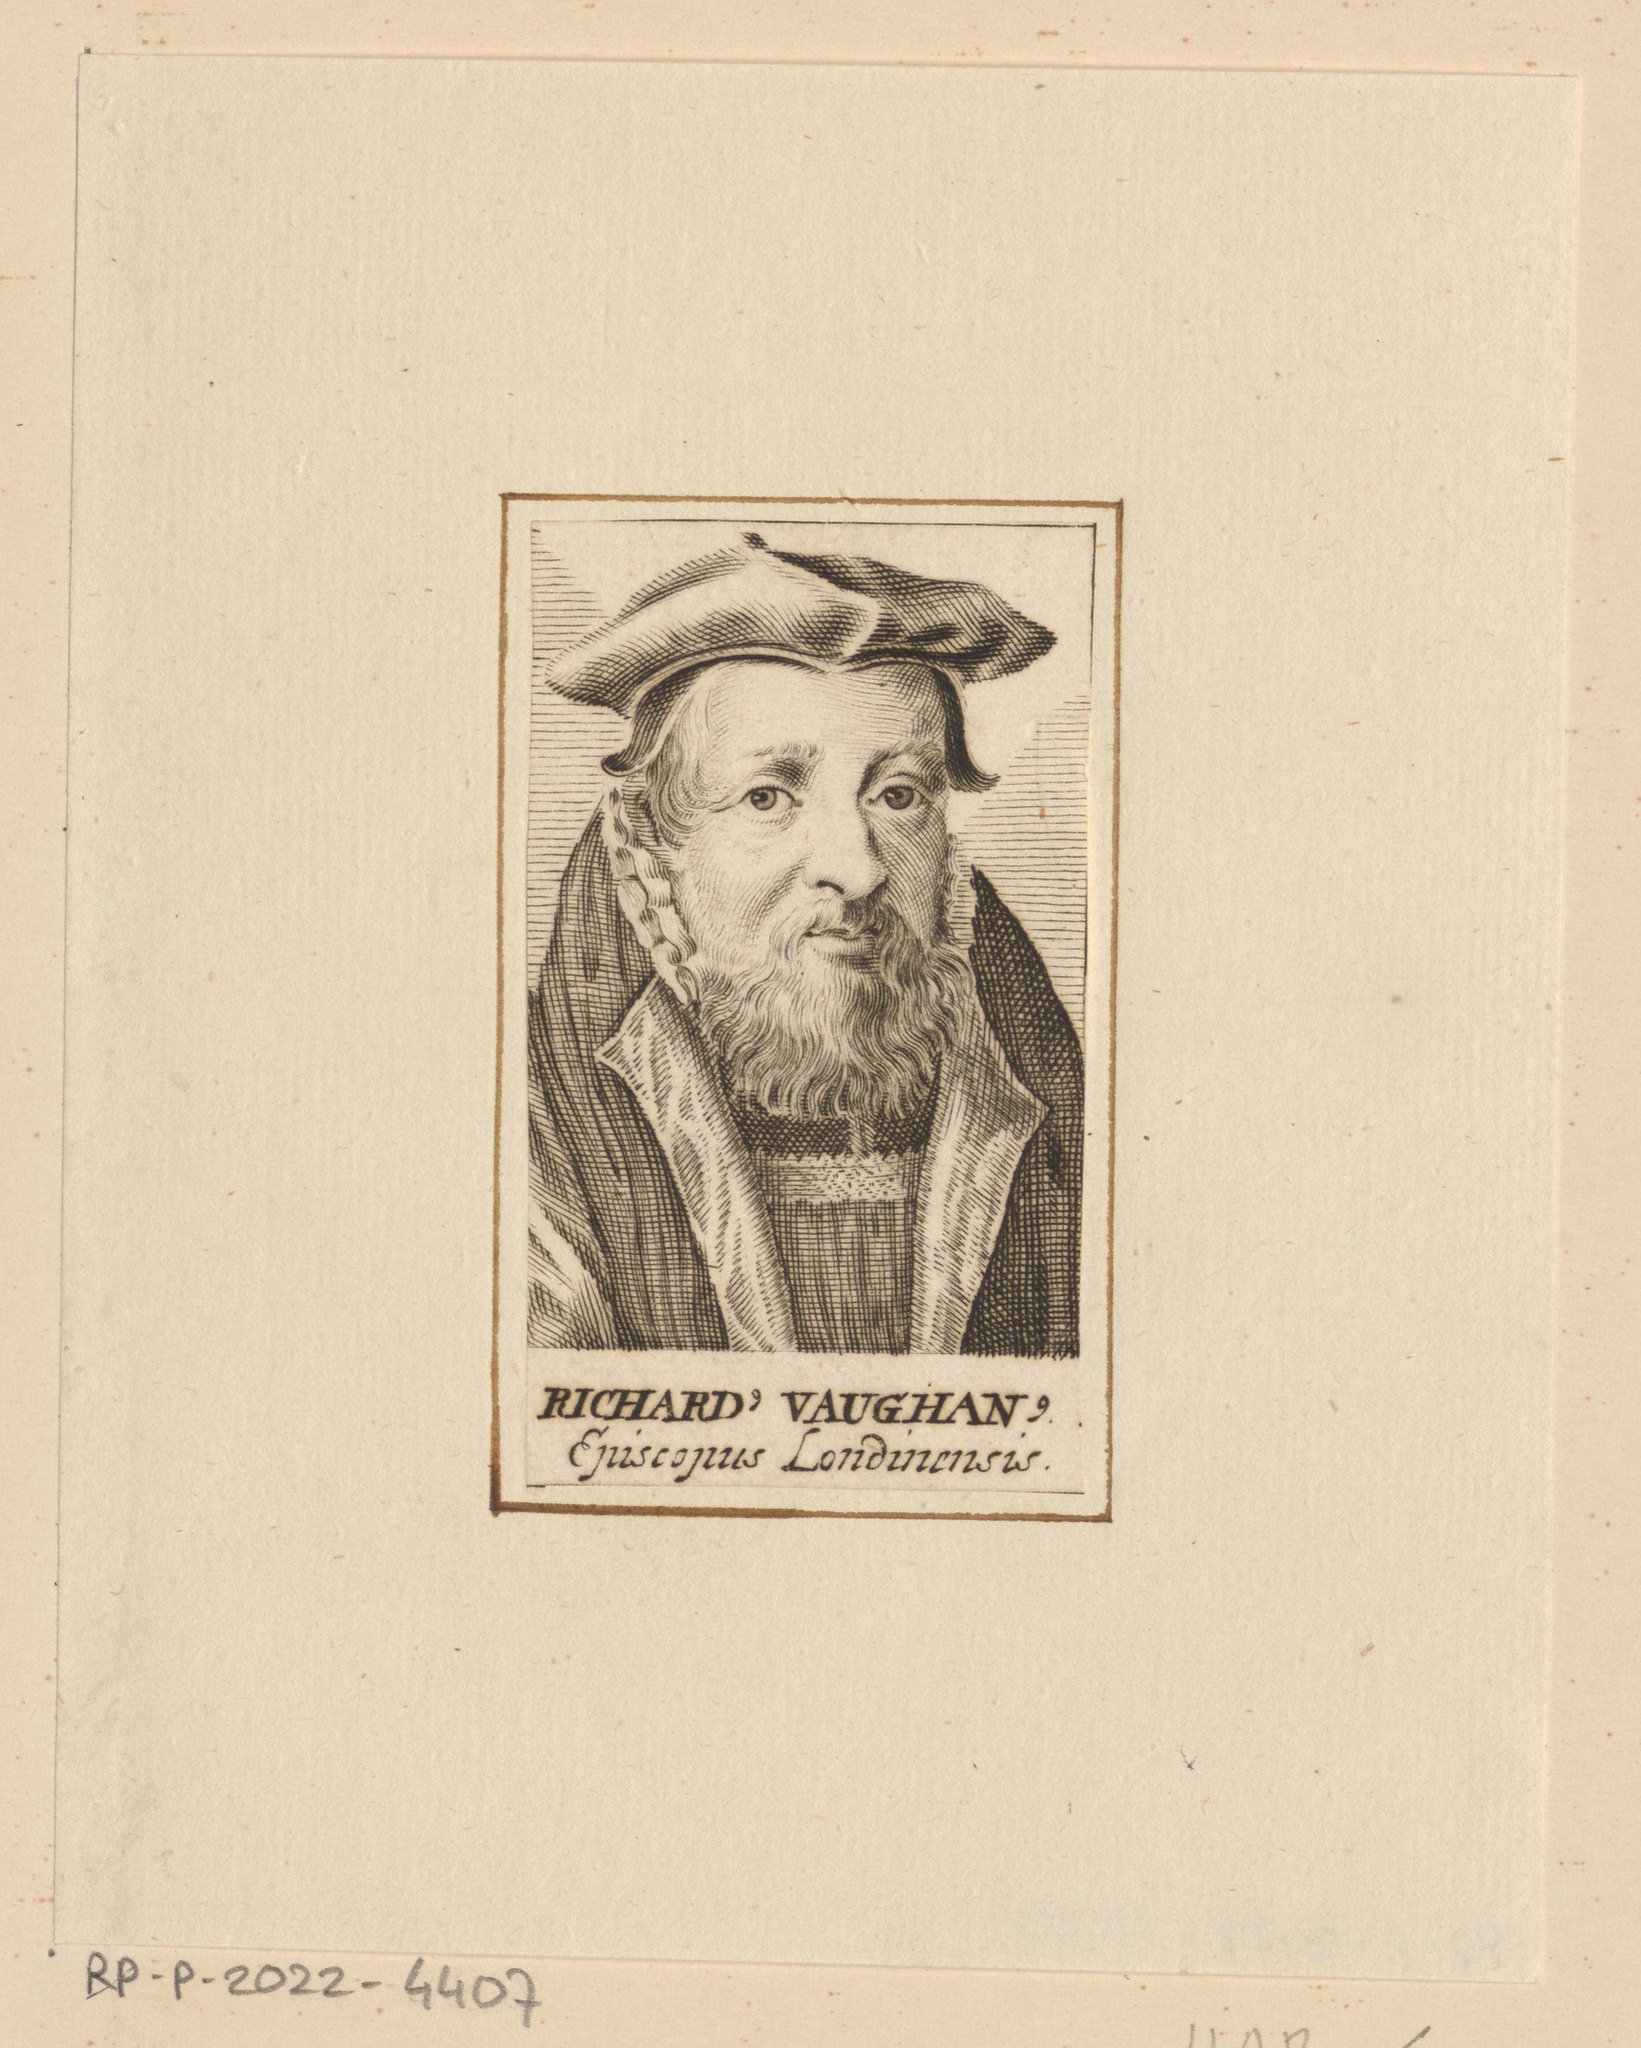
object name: print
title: Portret van Richard Vaughan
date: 1688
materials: paper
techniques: engraving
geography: nuremberg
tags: london, priest, archbishop, bishop, etc. (roman catholic), historical persons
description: Prent uit: Freher, Paul. Theatrum virorum eruditione clarorum. Neurenberg: Johann Hoffmann, 1688.